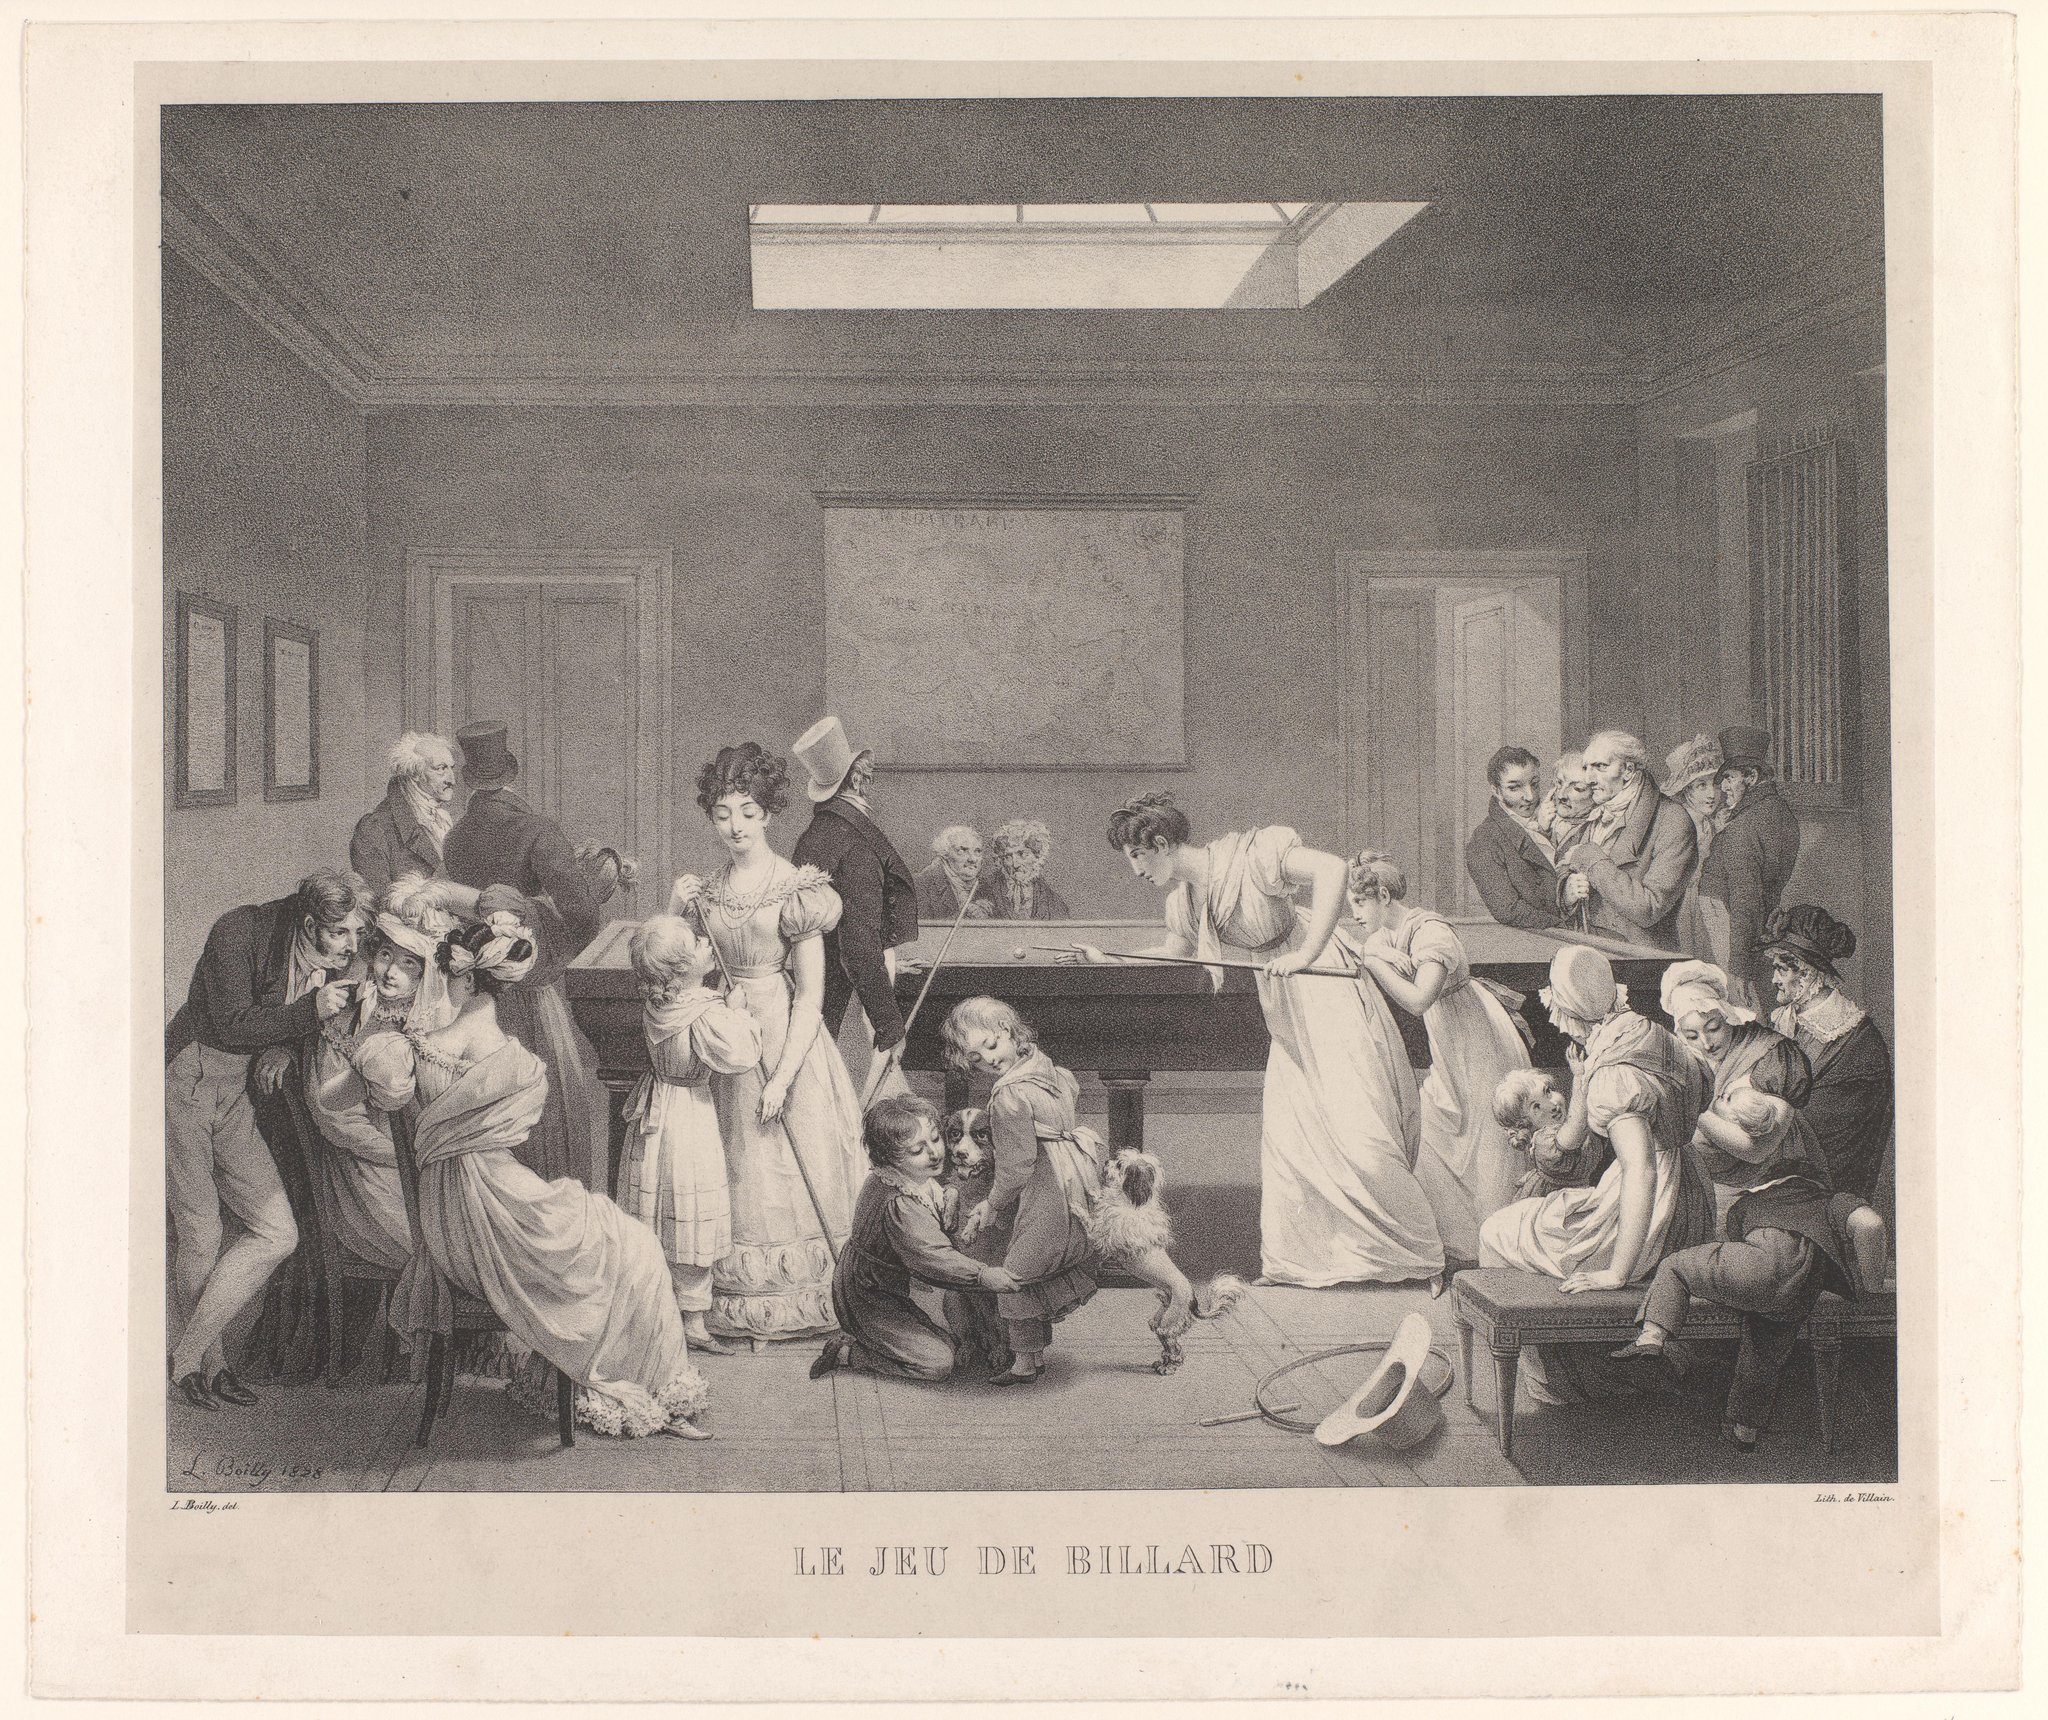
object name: print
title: Gezelschap in een biljartzaal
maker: françois jean villain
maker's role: printer, publisher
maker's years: 1790-1852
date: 1828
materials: paper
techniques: lithograph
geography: paris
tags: billiards, loose company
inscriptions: collector's mark: Lugt 2228a, collector's mark: Lugt 2760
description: Boilly vervaardigde in 1807 het schilderij 'Un jeu de billard', voorafgegaan door een studie. Het schilderij bevindt zich in de collectie van de Hermitage te Sint-Petersburg (inv.nr. GE 5666), de voorstudie in een Zwitserse particuliere collectie. De compositie is niet identiek aan deze prent, maar wel verwant.